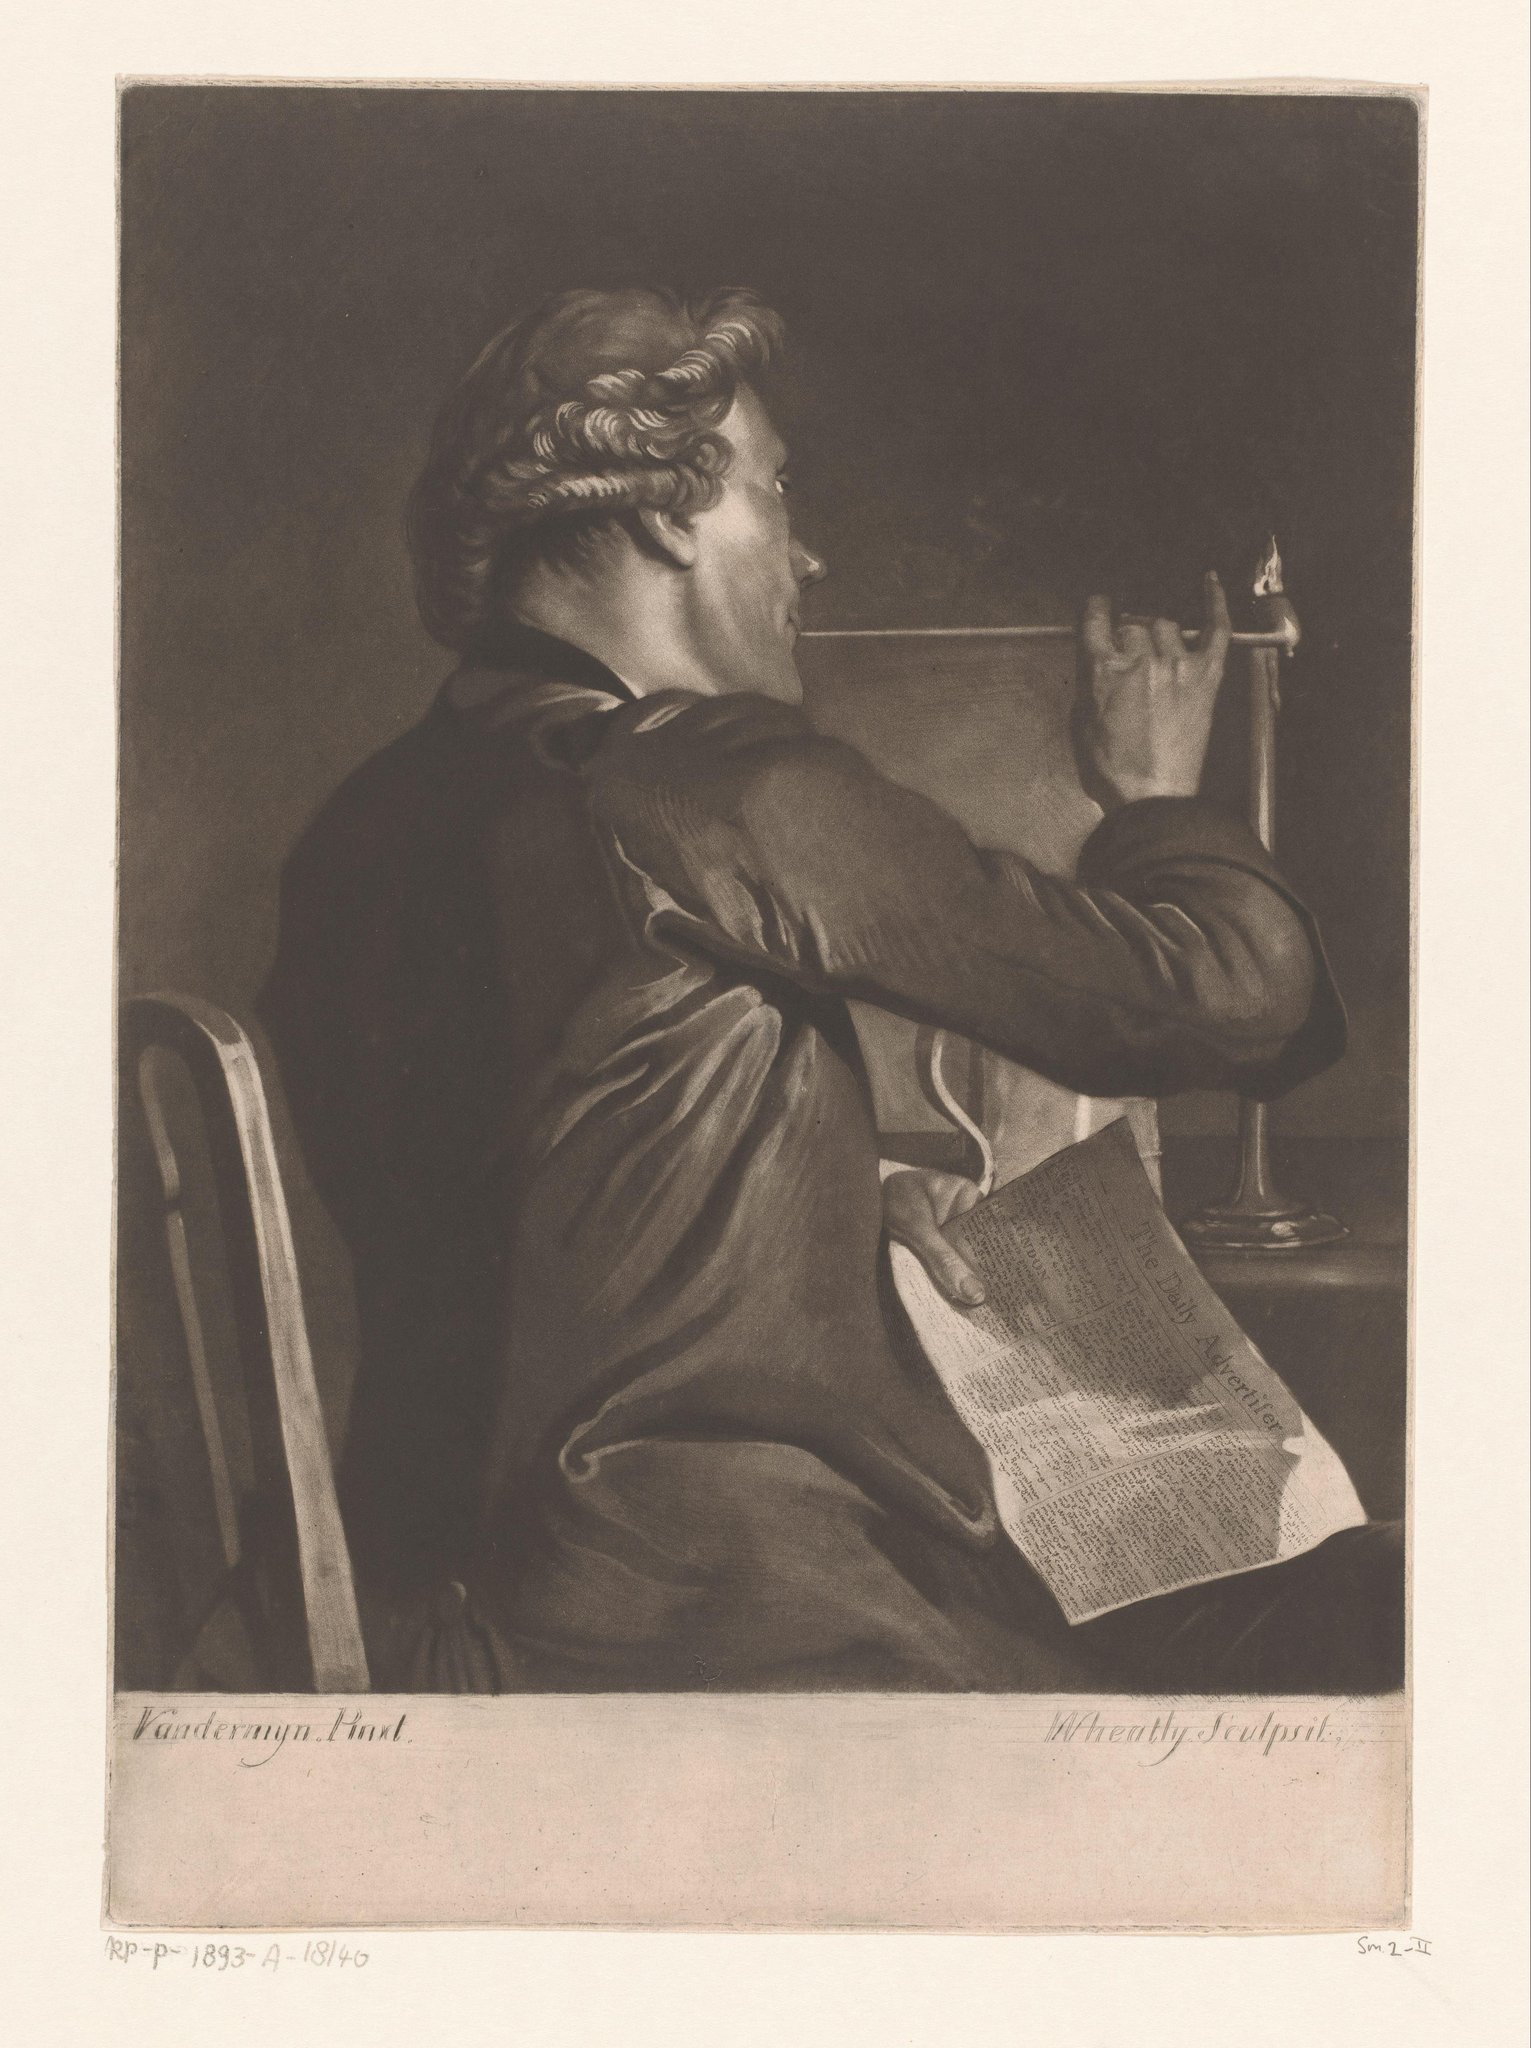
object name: print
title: Rokende man leest de krant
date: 1763-1799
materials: paper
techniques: mezzotint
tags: adult man, pipe ~ tobacco, newspaper, news-sheet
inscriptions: collector's mark: Lugt 2228